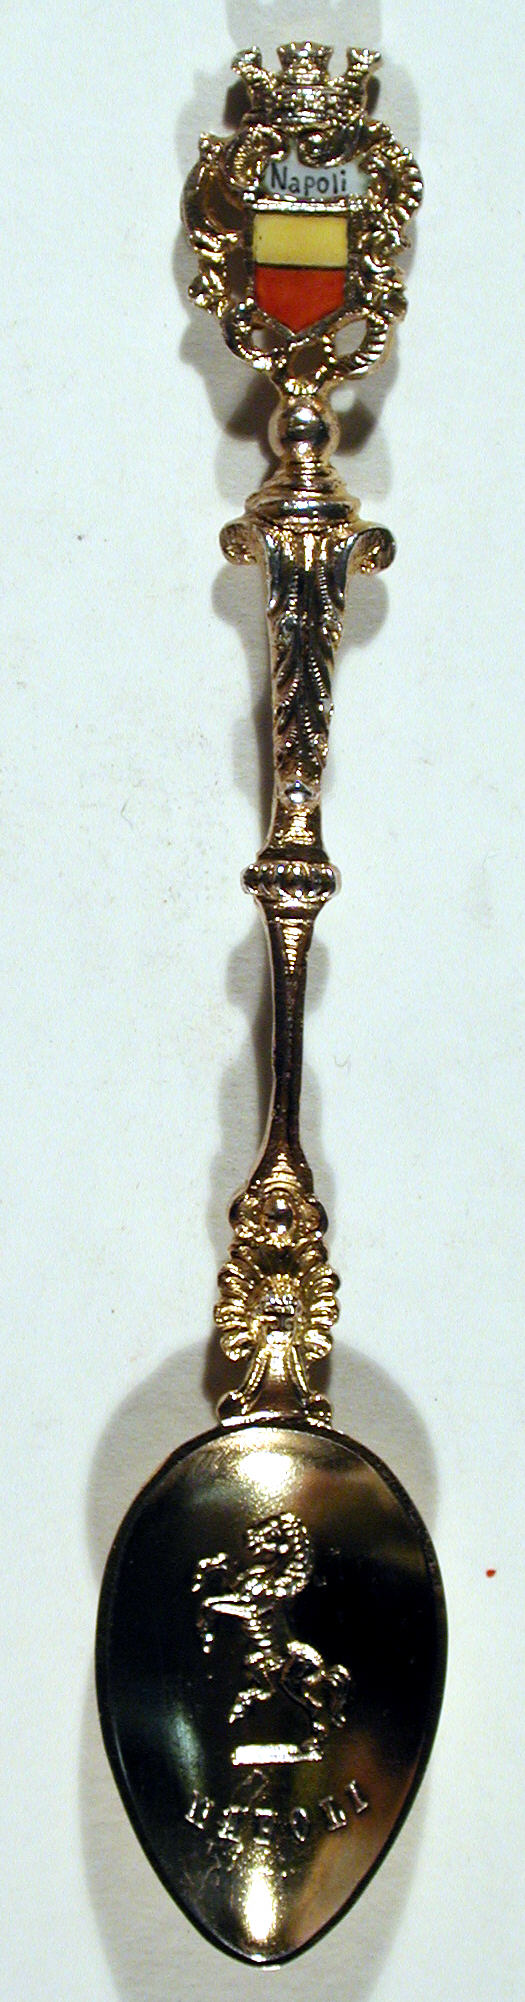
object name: souvenir spoon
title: Souvenir spoon with arms of Naples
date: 1867-1900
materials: enamel, silver gilt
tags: coat of arms